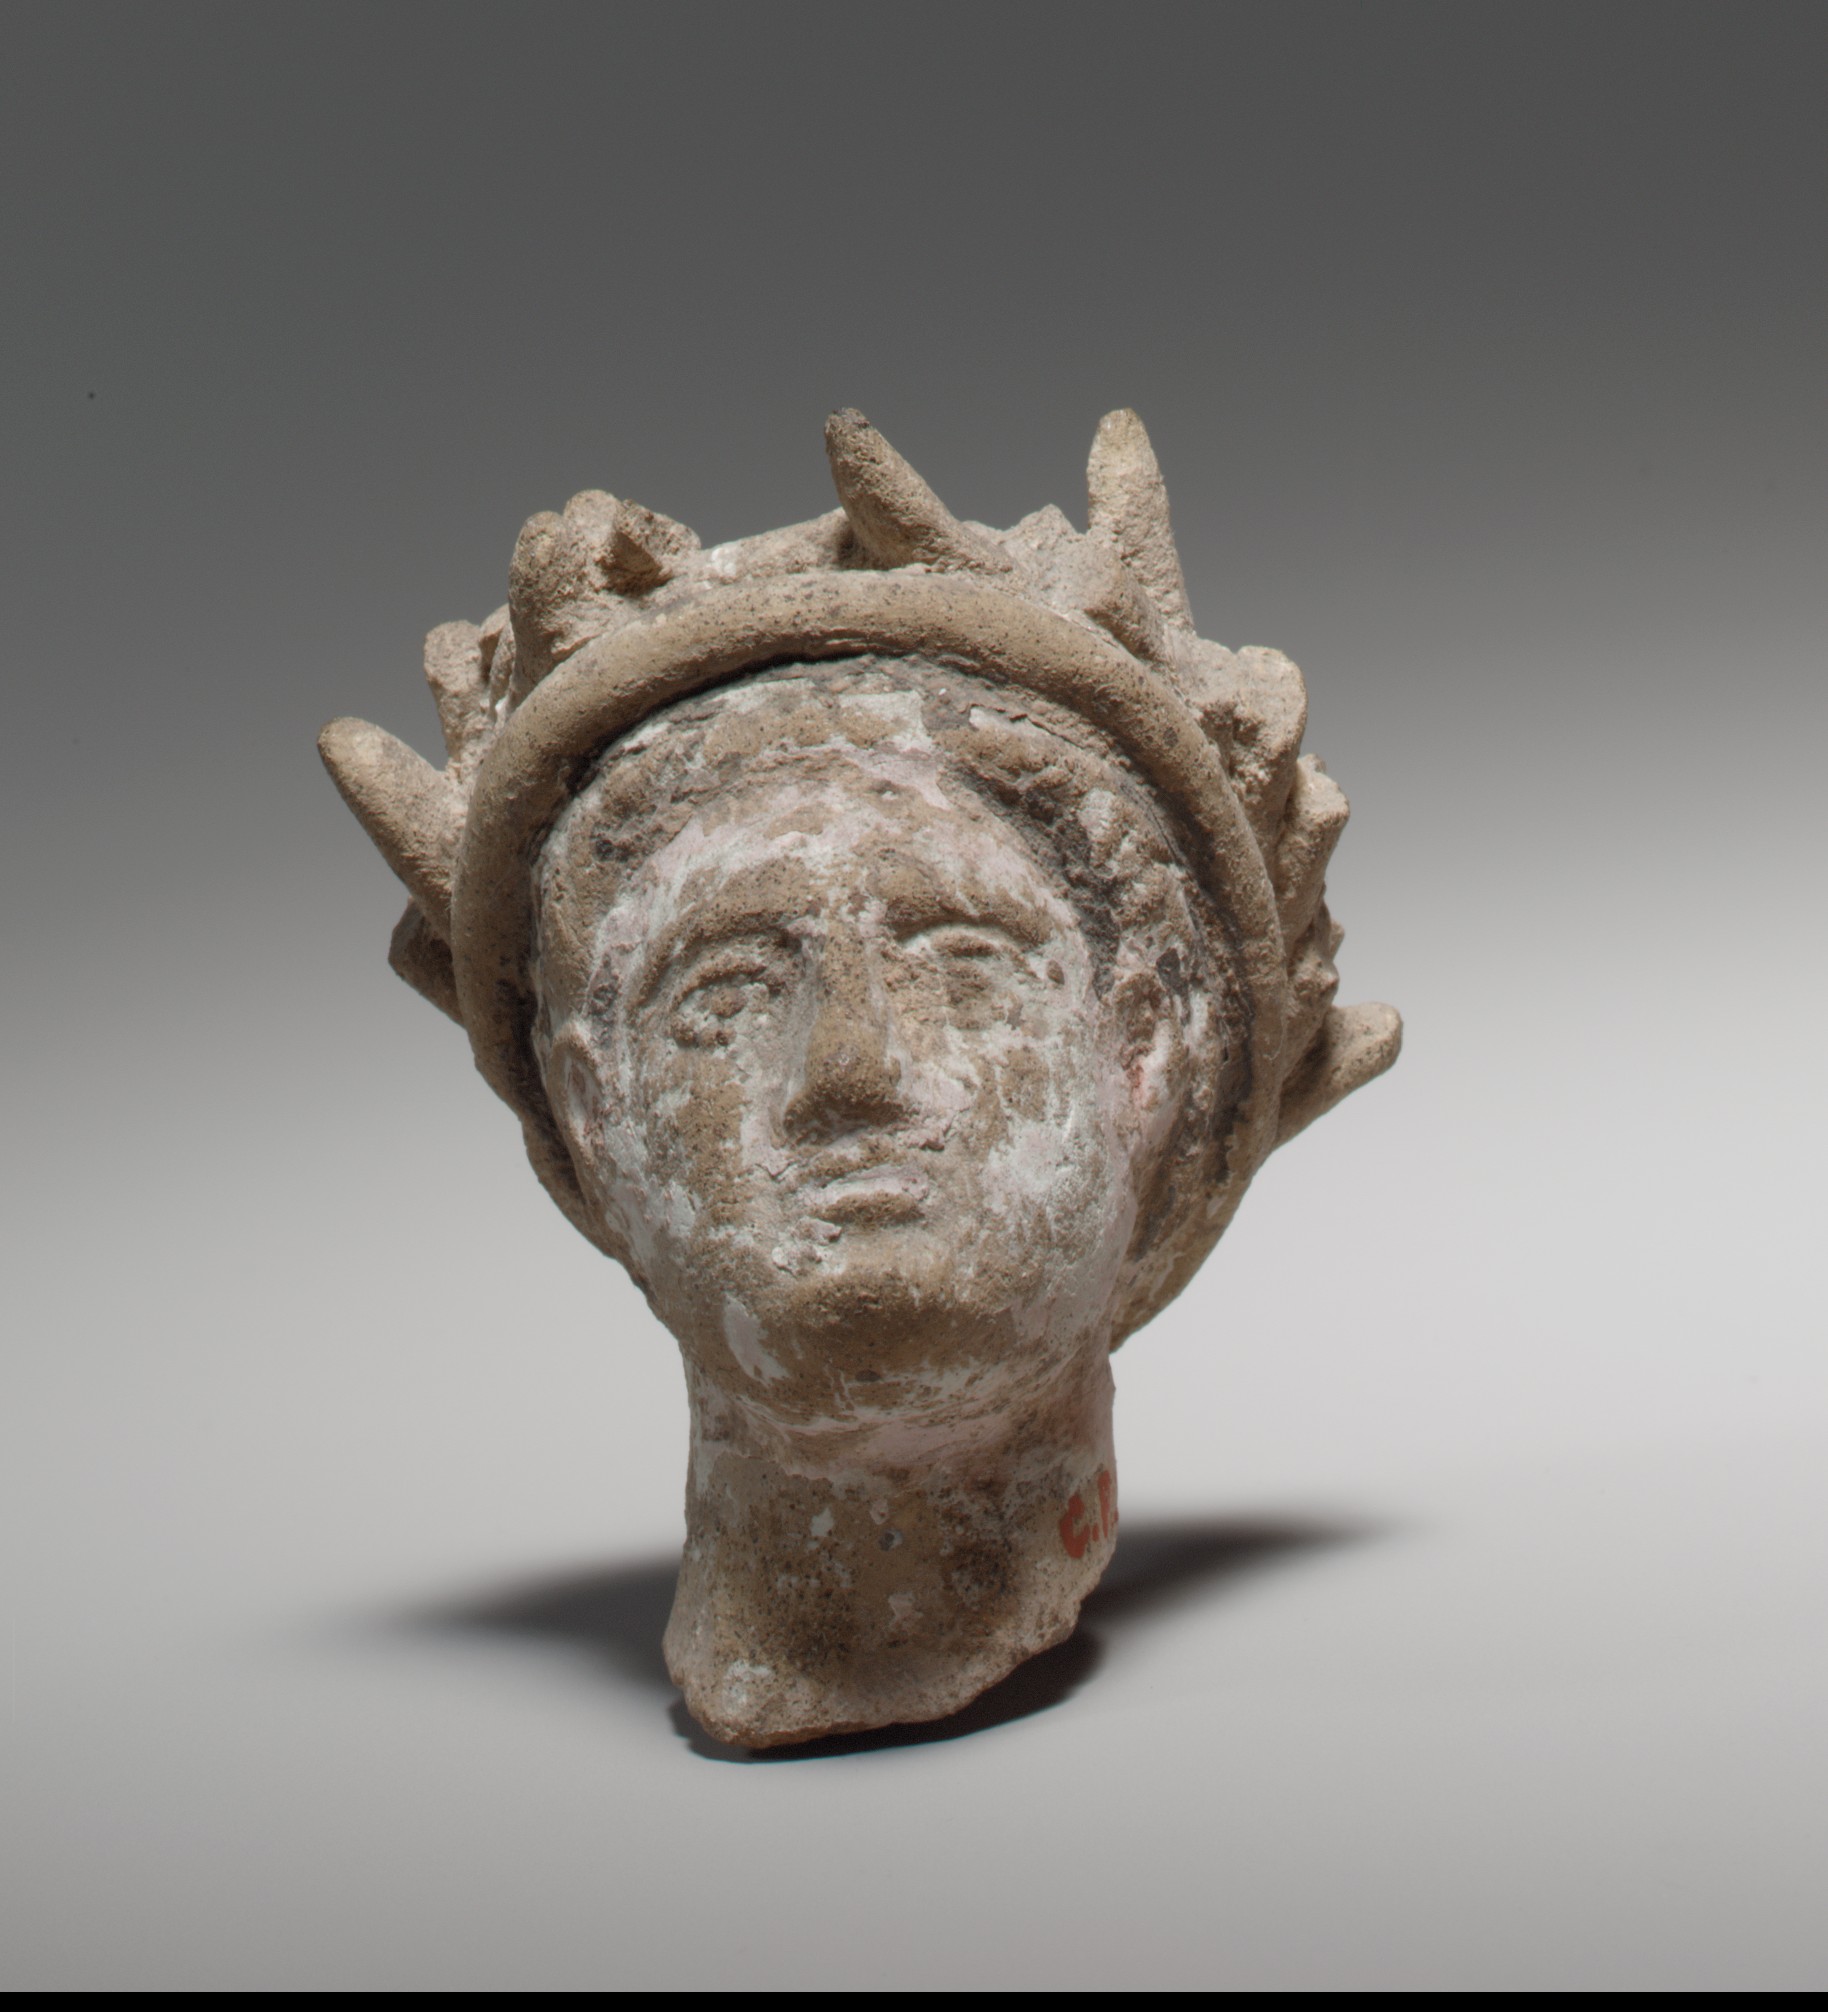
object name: head of a votary or deity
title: Terracotta male head wearing a wreath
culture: cypriot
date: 300-201 BCE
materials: terracotta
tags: heads,men,wreaths